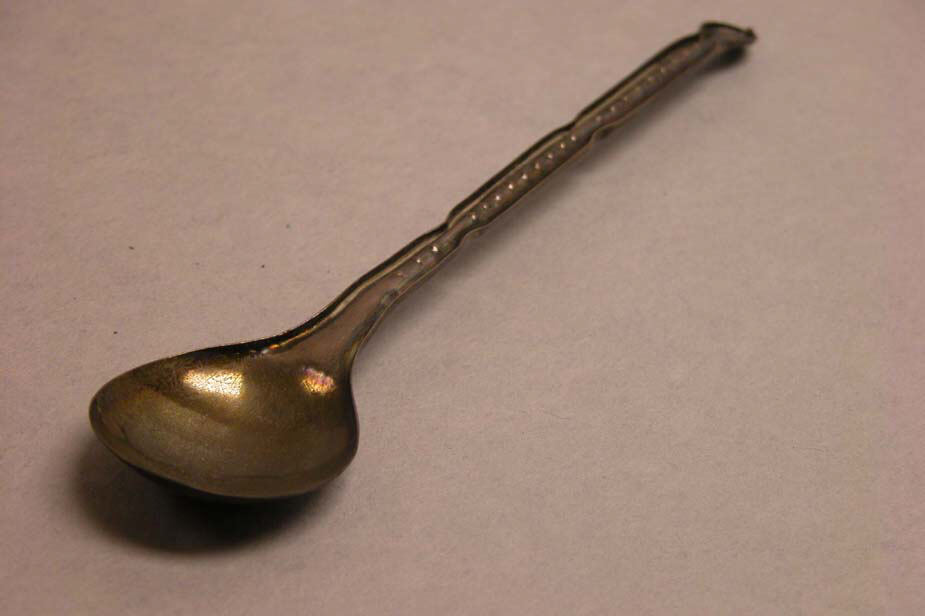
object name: spoon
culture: japanese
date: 1801-1900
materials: silver